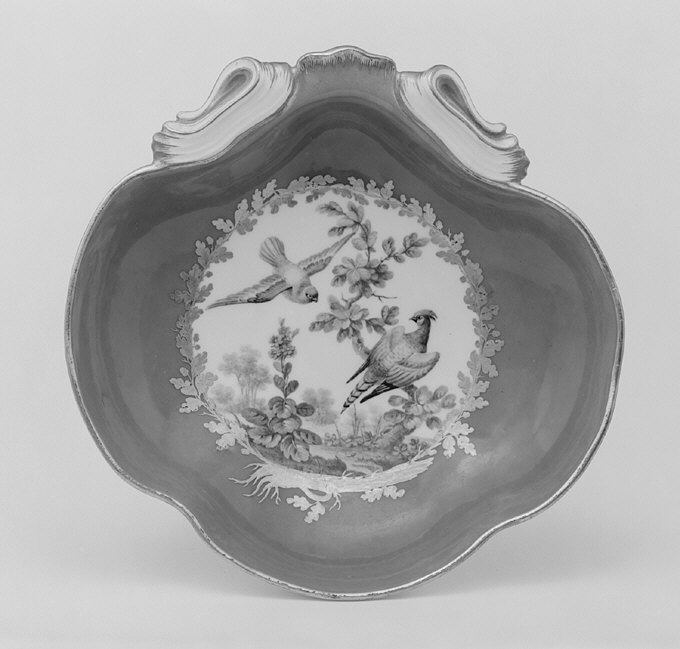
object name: fruit dish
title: Fruit dish (compotier coquille) (one of a pair) (part of a service)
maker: sèvres manufactory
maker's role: manufactory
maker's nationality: french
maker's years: 1740-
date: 1771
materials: soft paste porcelain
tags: birds,trees